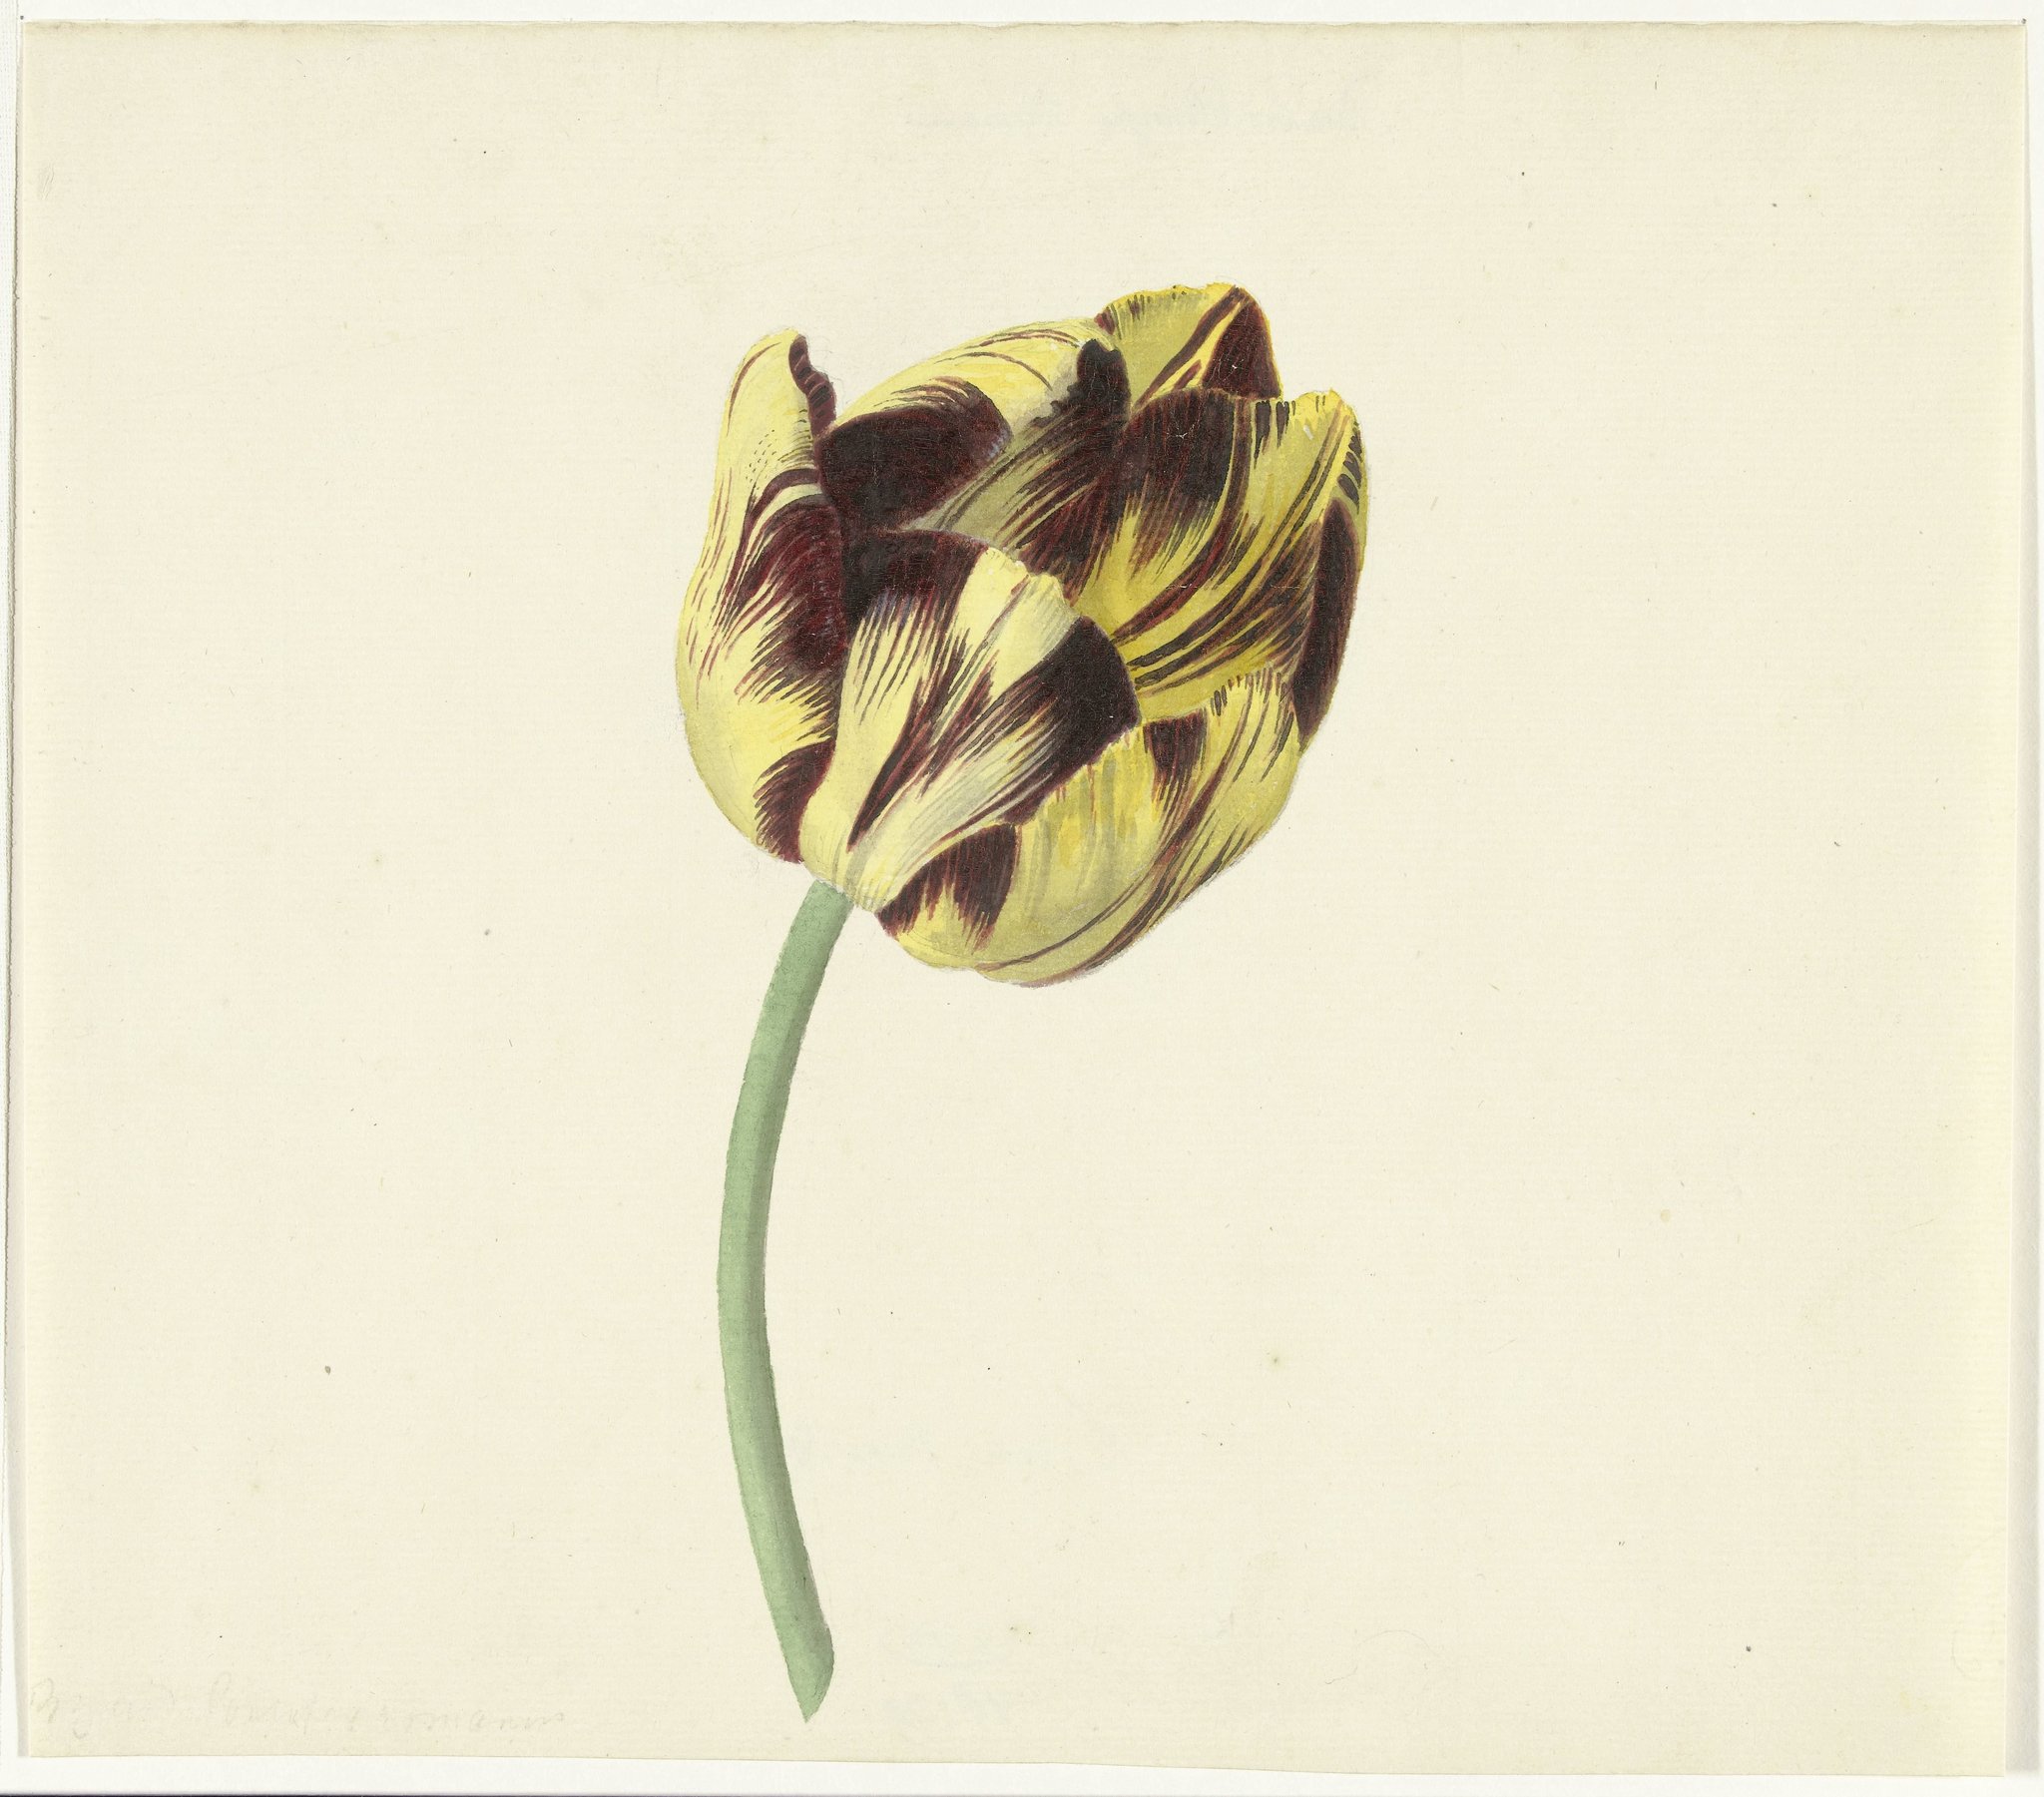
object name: drawing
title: Tulp genaamd Bizard Pontifex Romanus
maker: cornelis van noorde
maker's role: draughtsman, print maker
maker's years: 1731-1795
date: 1741-1795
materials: chalk, paper, watercolor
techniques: brush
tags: flowers: tulip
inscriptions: inscription: ‘Bizard Pontifex Romanus’